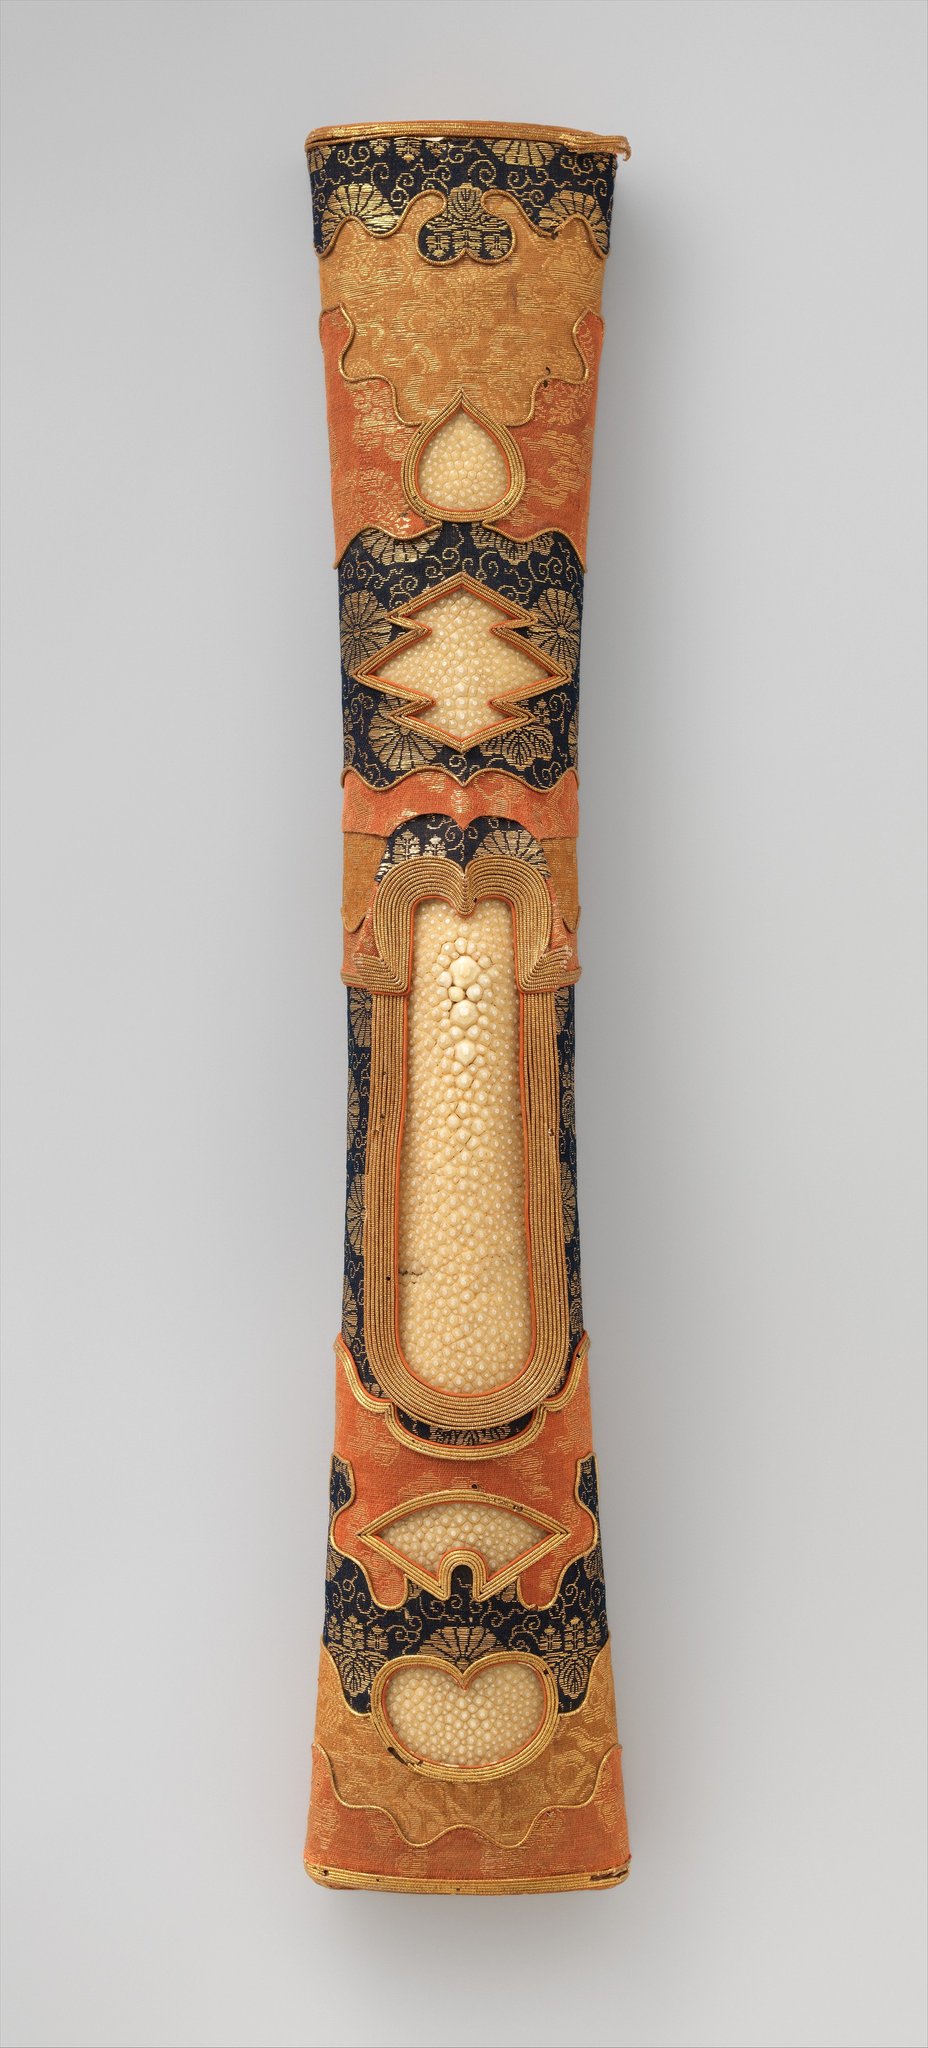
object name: decorated shark skin i kazari zame i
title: Decorated "Shark" Skin (Kazari-zame)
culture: japanese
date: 1800-1850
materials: gold, paper, silk, wood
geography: japan